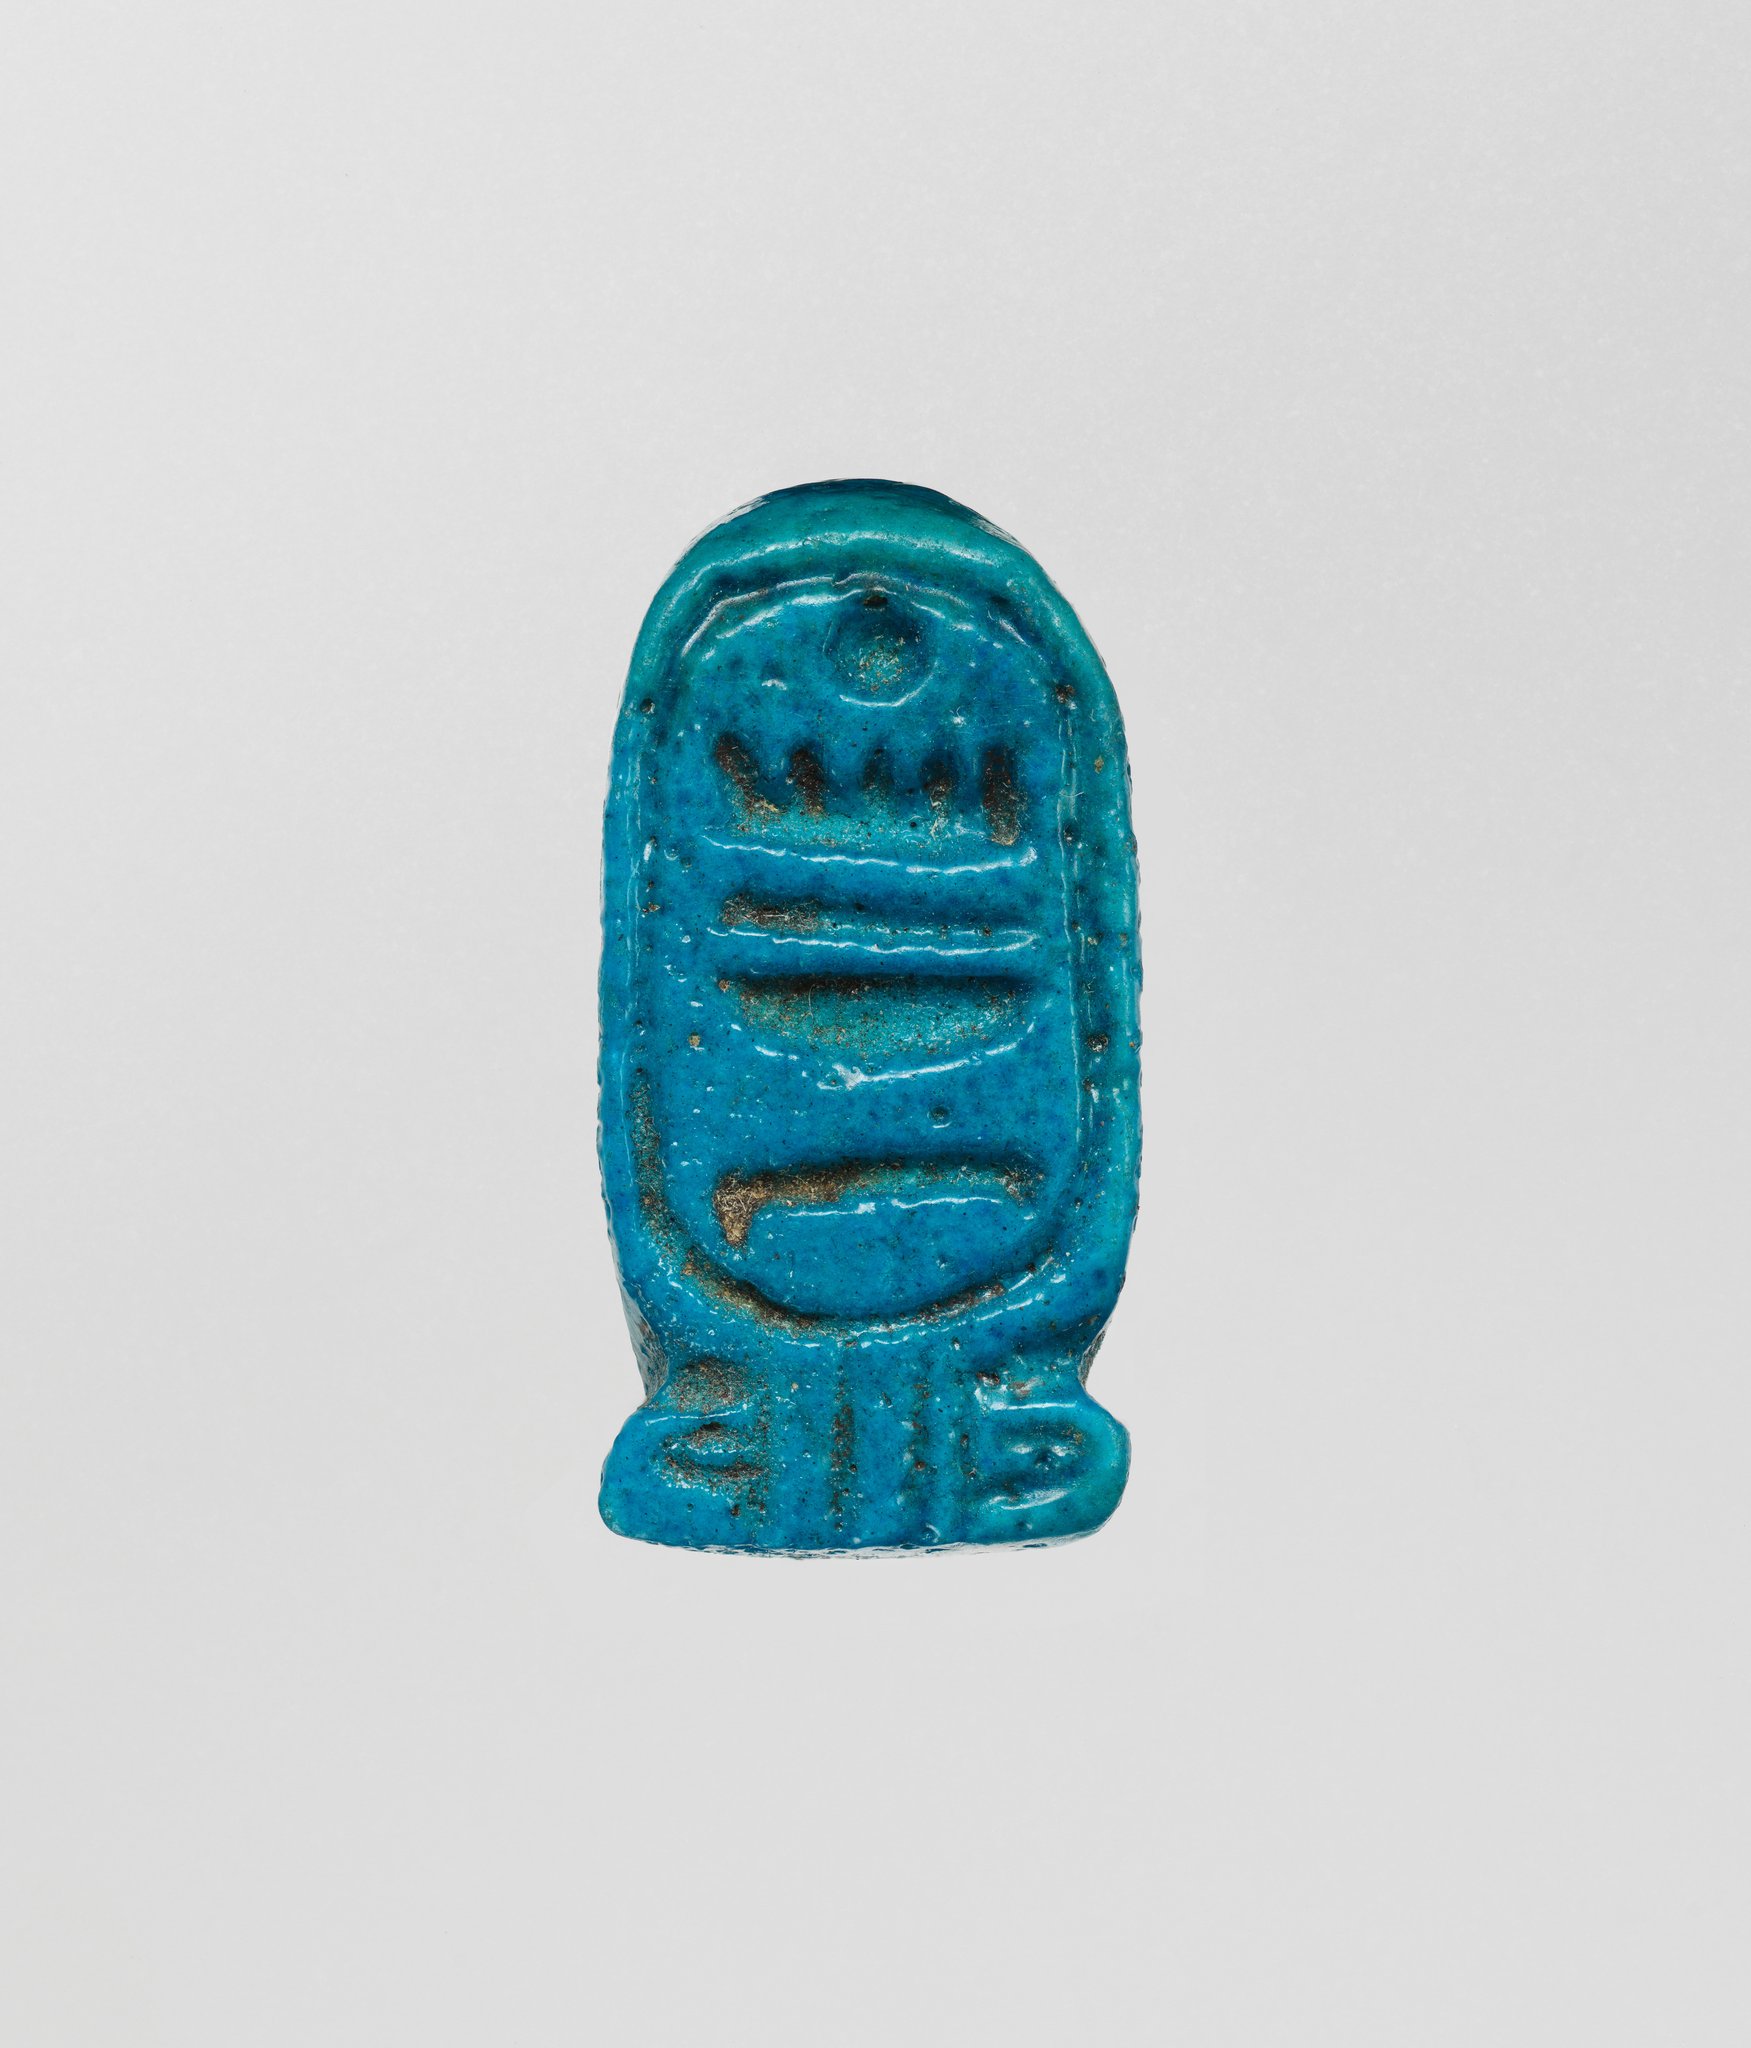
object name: ring, signet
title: Signet ring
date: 1070-712 BCE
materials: faience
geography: egypt